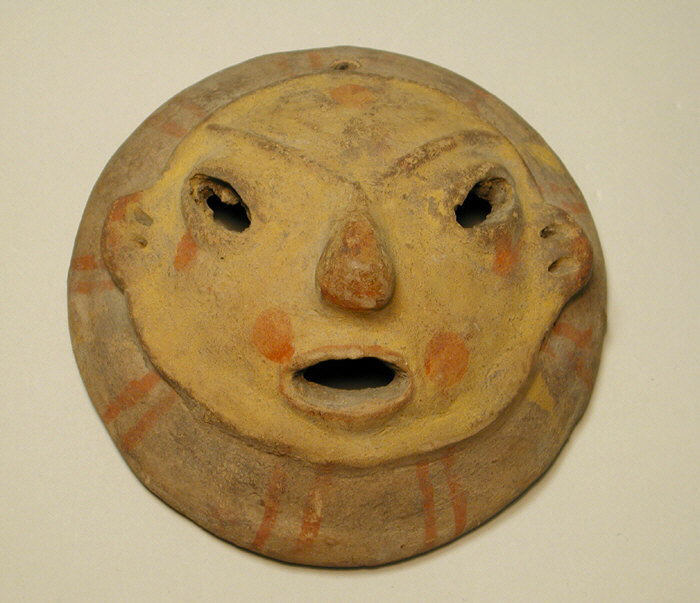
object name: mask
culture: tlatilco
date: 1200-801 BCE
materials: ceramic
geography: mexico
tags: faces